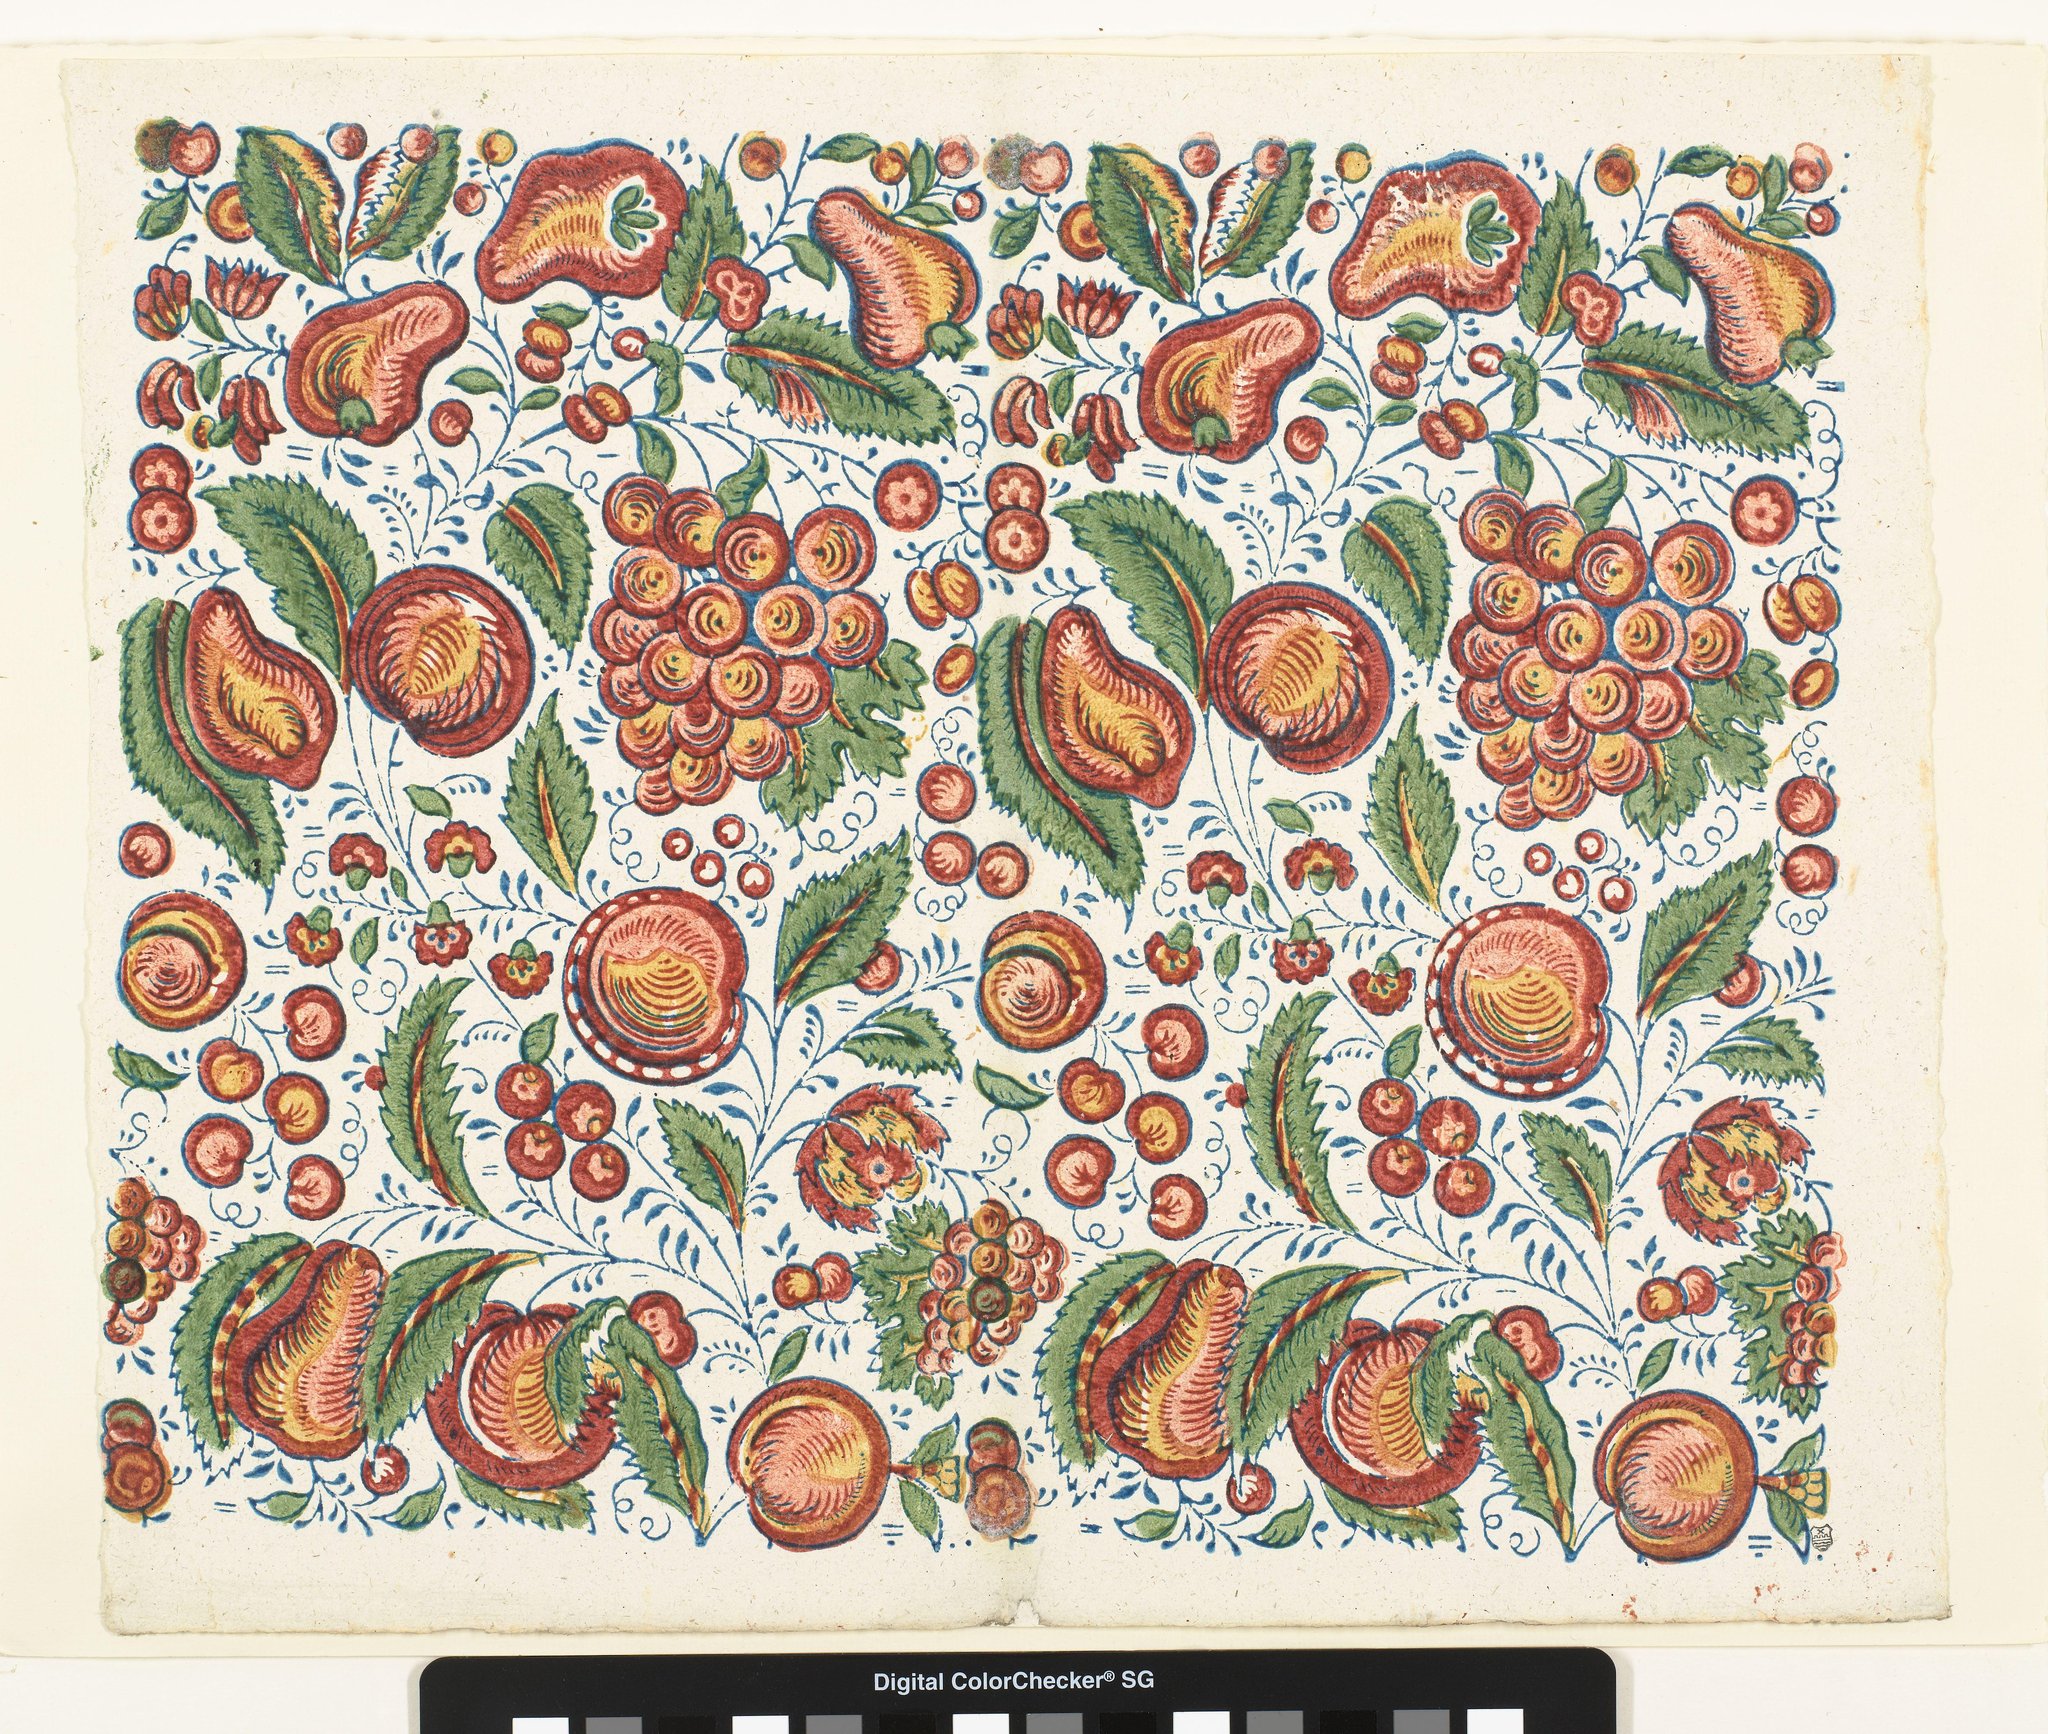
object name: printed paper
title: Blad met ranken met vruchten waaronder peren en druiventros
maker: Anonymous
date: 1750-1799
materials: paper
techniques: printing block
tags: ornament derived from plant forms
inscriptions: collector's mark: Lugt 2760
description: Blad met ranken met vruchten waaronder peren een druiventros. Links en rechts identieke helften.